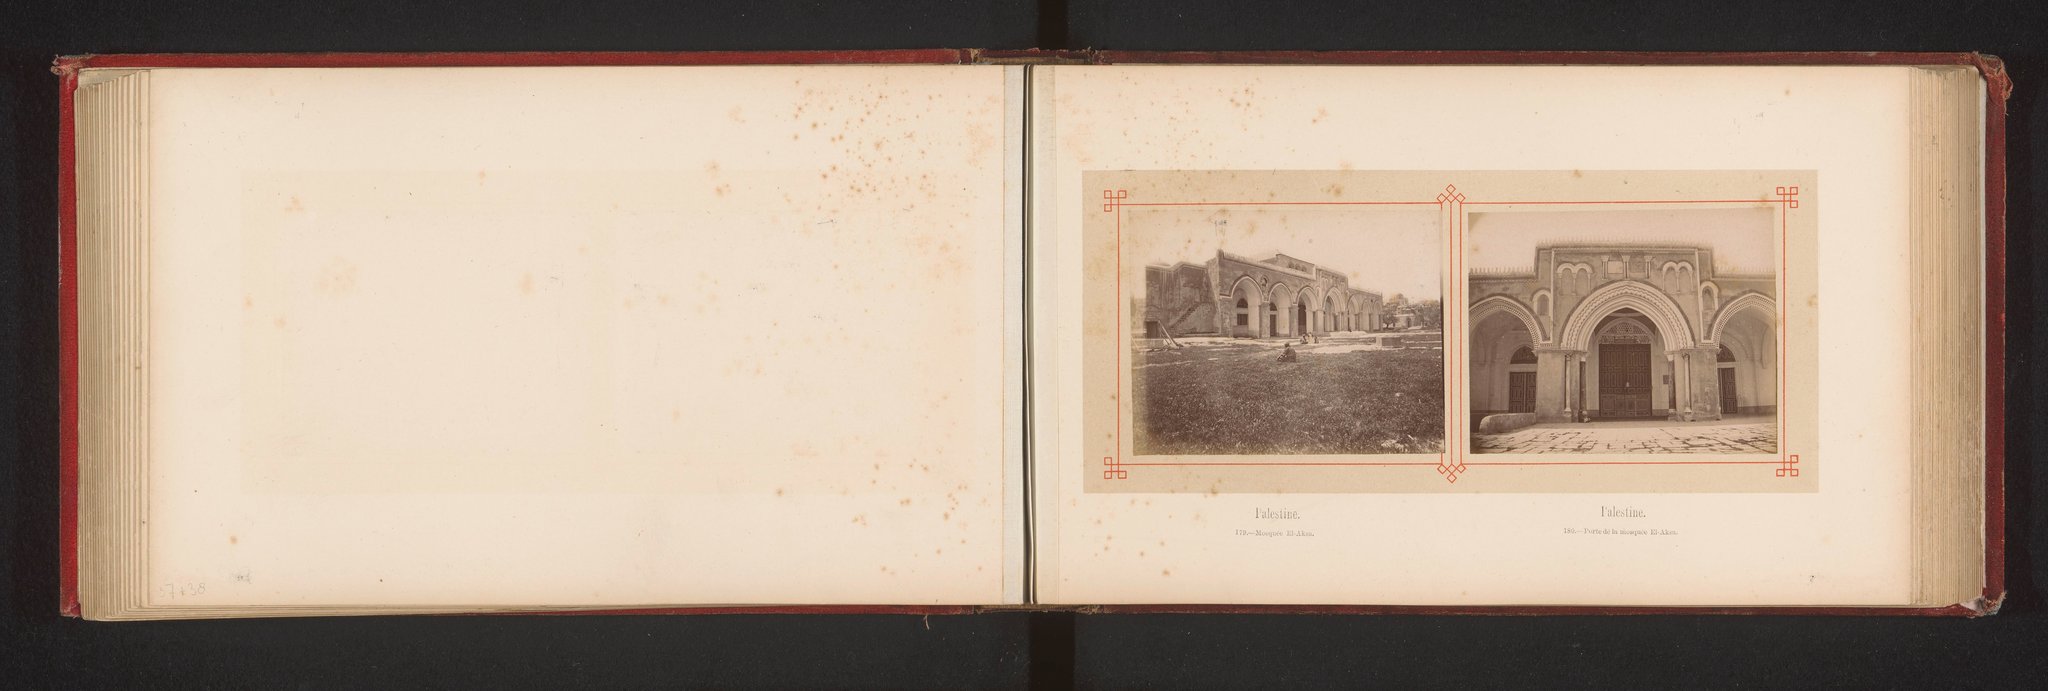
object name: photograph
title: Palestine - 179.- Mosquée El-Aksa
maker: félix bonfils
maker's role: fotograaf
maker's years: 1831-1885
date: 1873-1878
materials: photographic support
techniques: albumen print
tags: temple, shrine ~ islam, mohammedanism